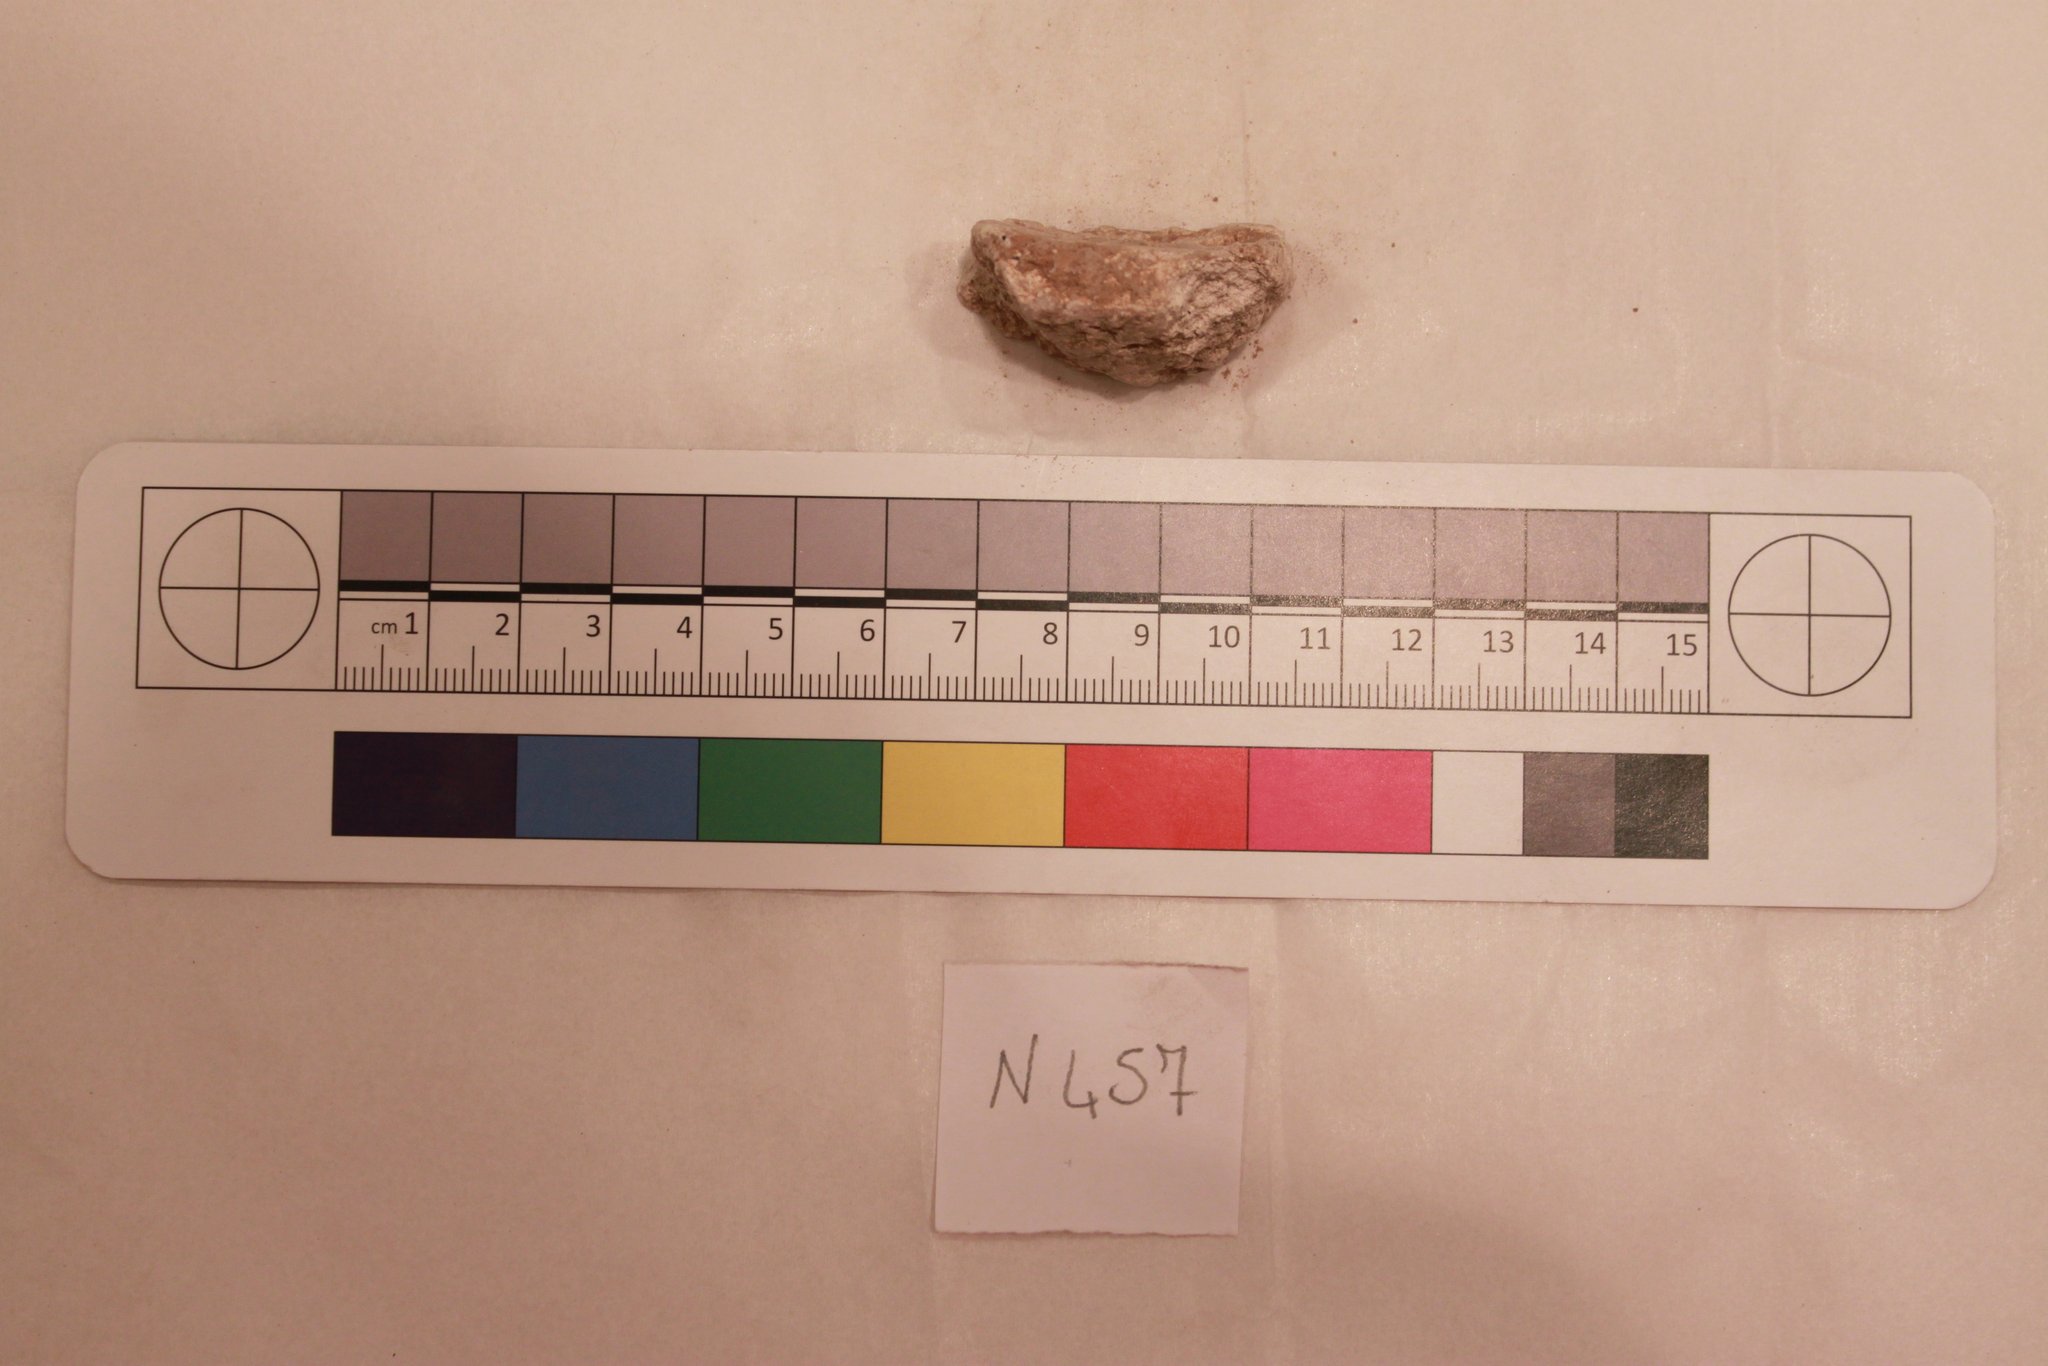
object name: fragment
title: Stucco Fragment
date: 701-1200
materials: plaster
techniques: carving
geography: iran